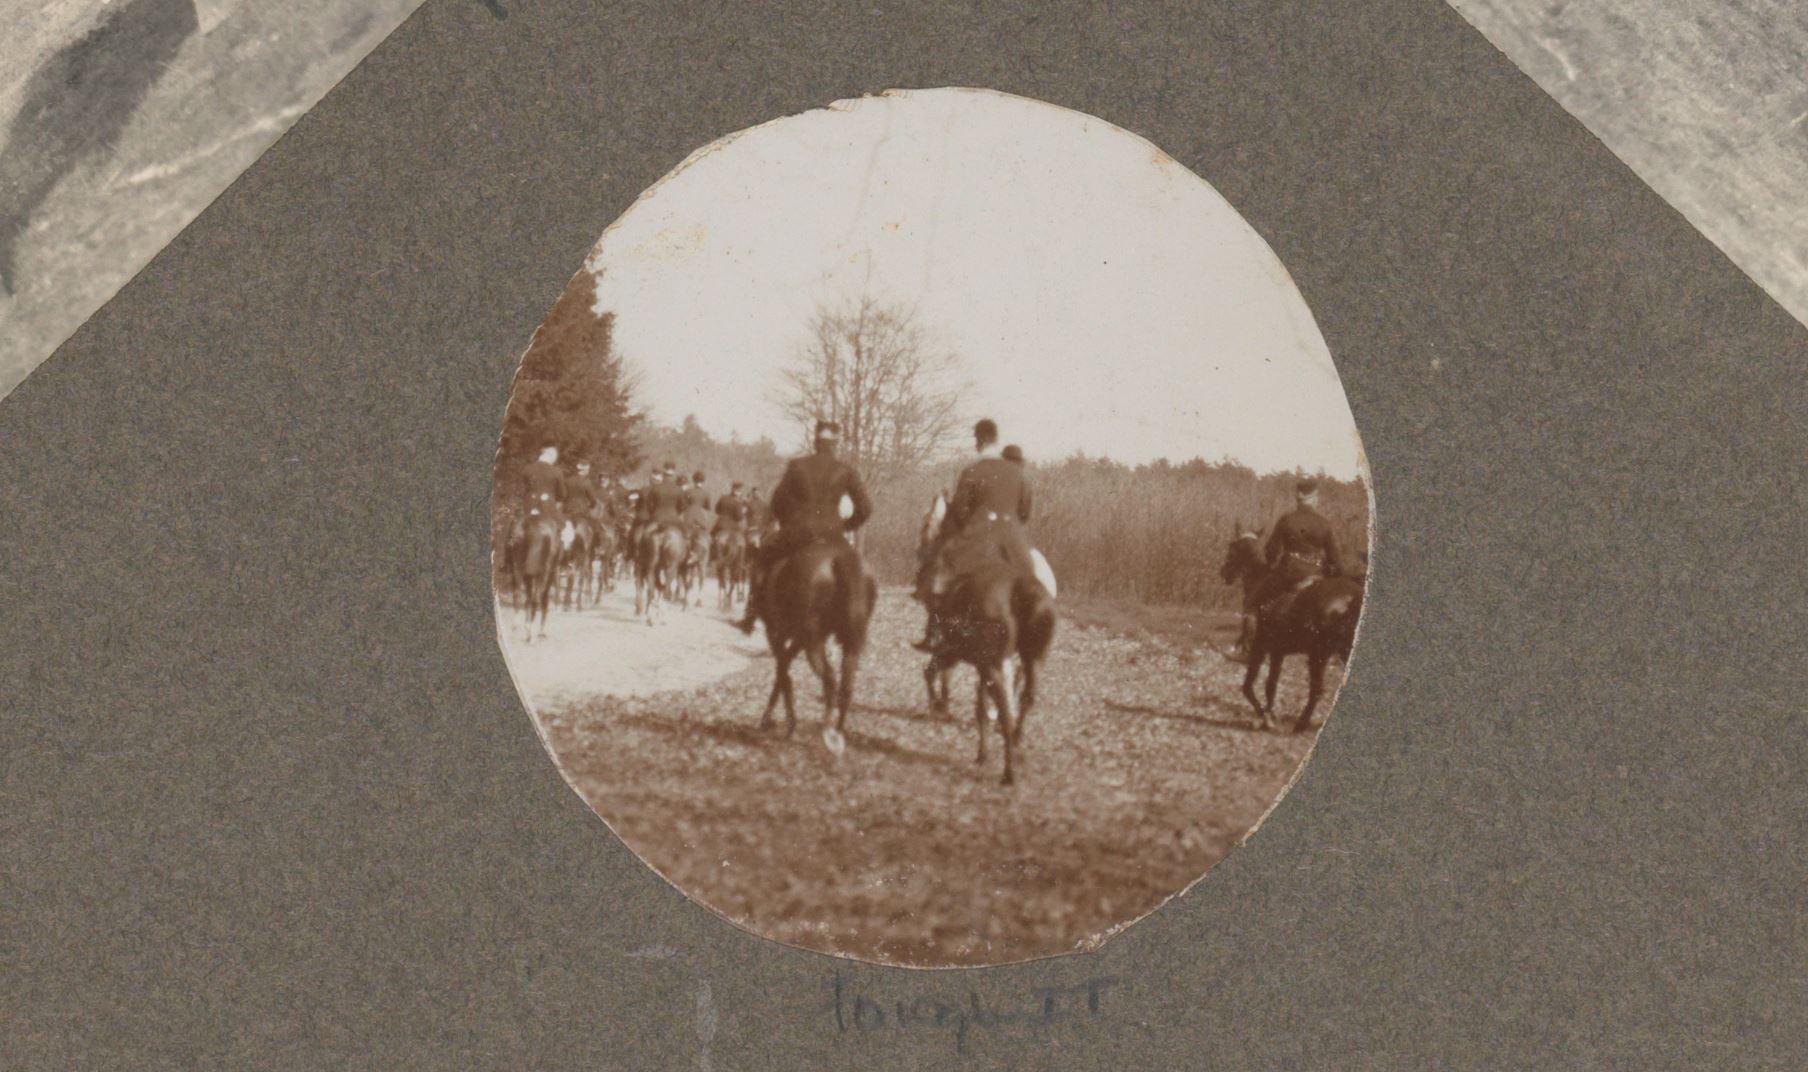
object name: photograph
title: Ruitertafereel op Koninklijke Houtvesterij Het Loo: ruiters op de rug gezien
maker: Anonymous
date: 1900-1925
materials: photographic support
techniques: collodion silver print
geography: het loo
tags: riding a horse, ass, or mule; rider, horseman, hunting, chase, hunting-ground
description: Onderdeel van Fotoalbum van de heer Brams, opperhoutvester van koningin Wilhelmina op Koninklijke Houtvesterij Het Loo.